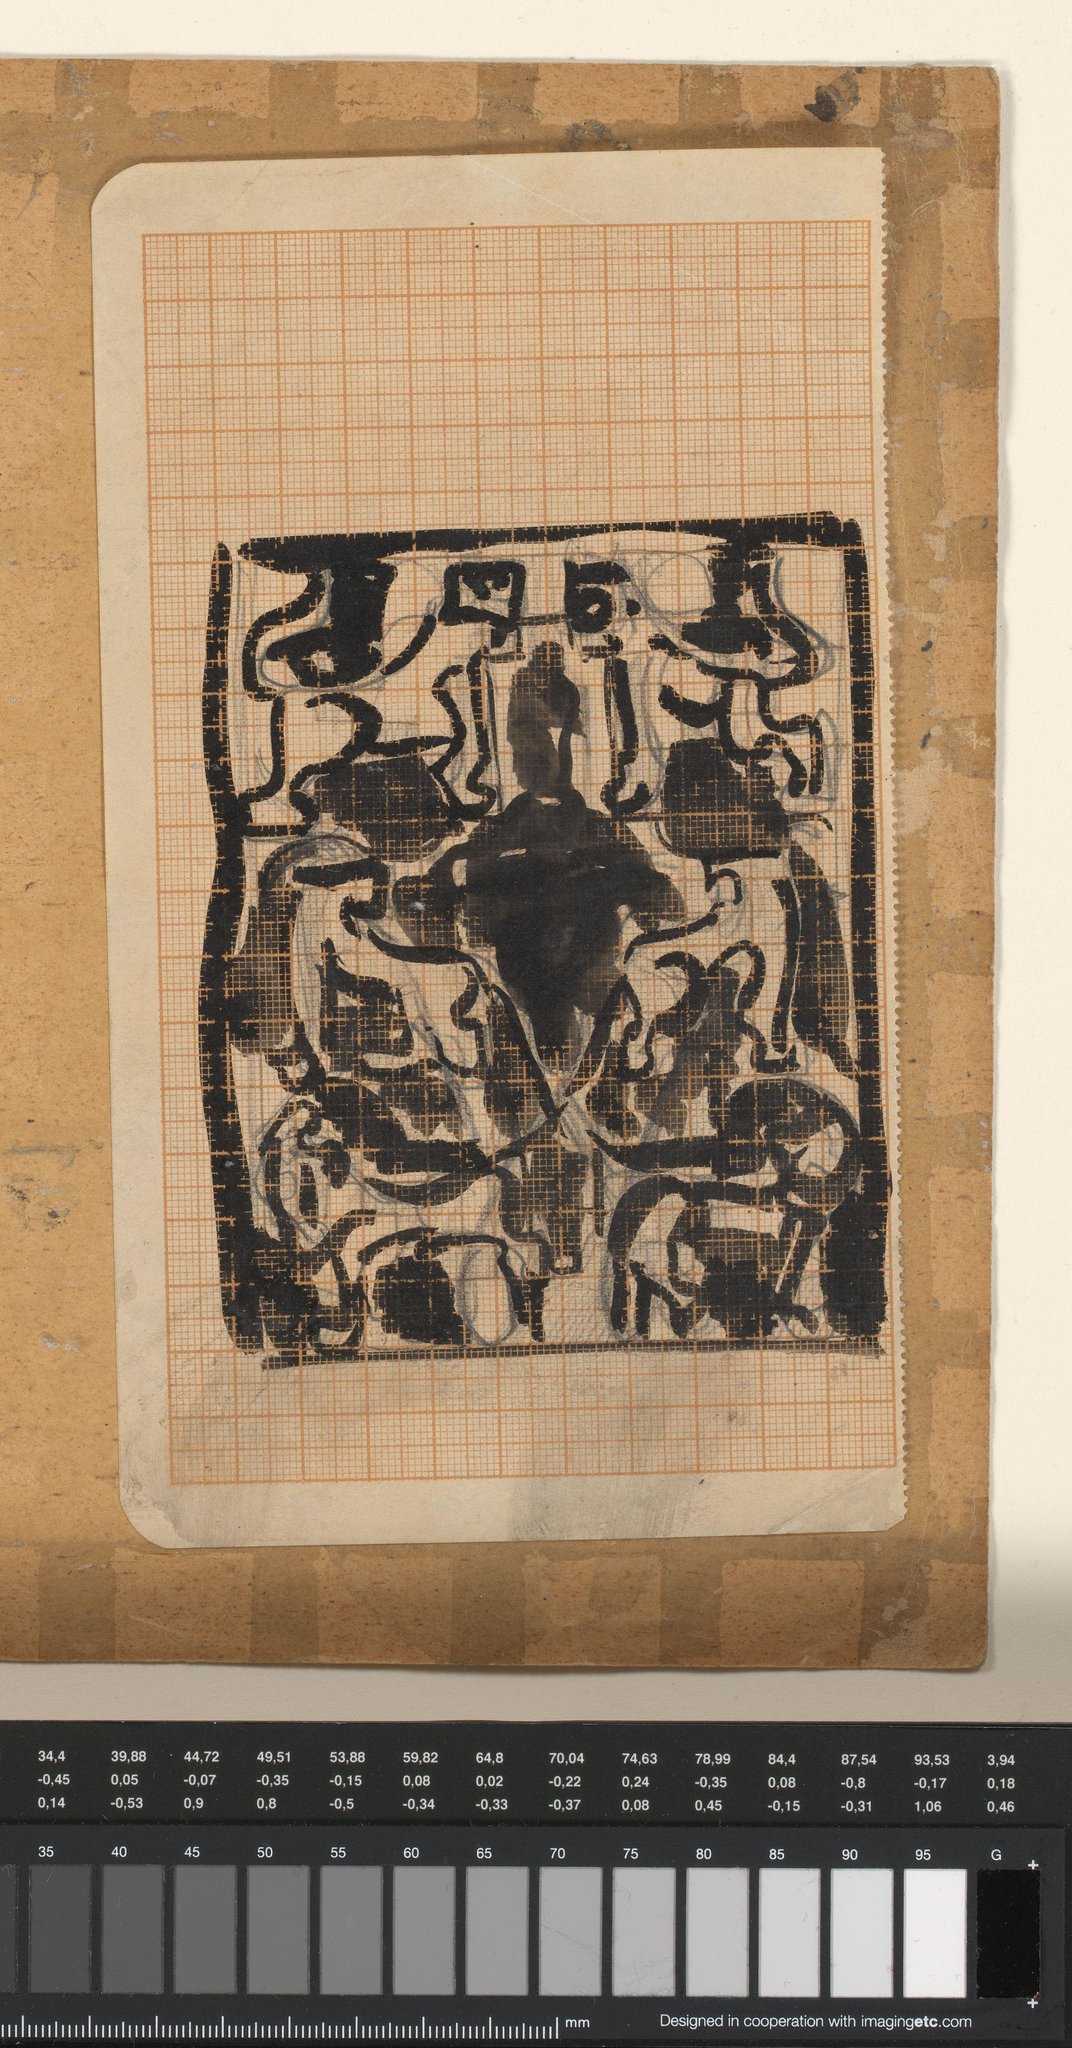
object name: design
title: Decoratief ontwerp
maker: carel adolph lion cachet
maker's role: draughtsman, print maker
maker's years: 1864-1945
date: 1874-1945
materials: pencil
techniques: brush